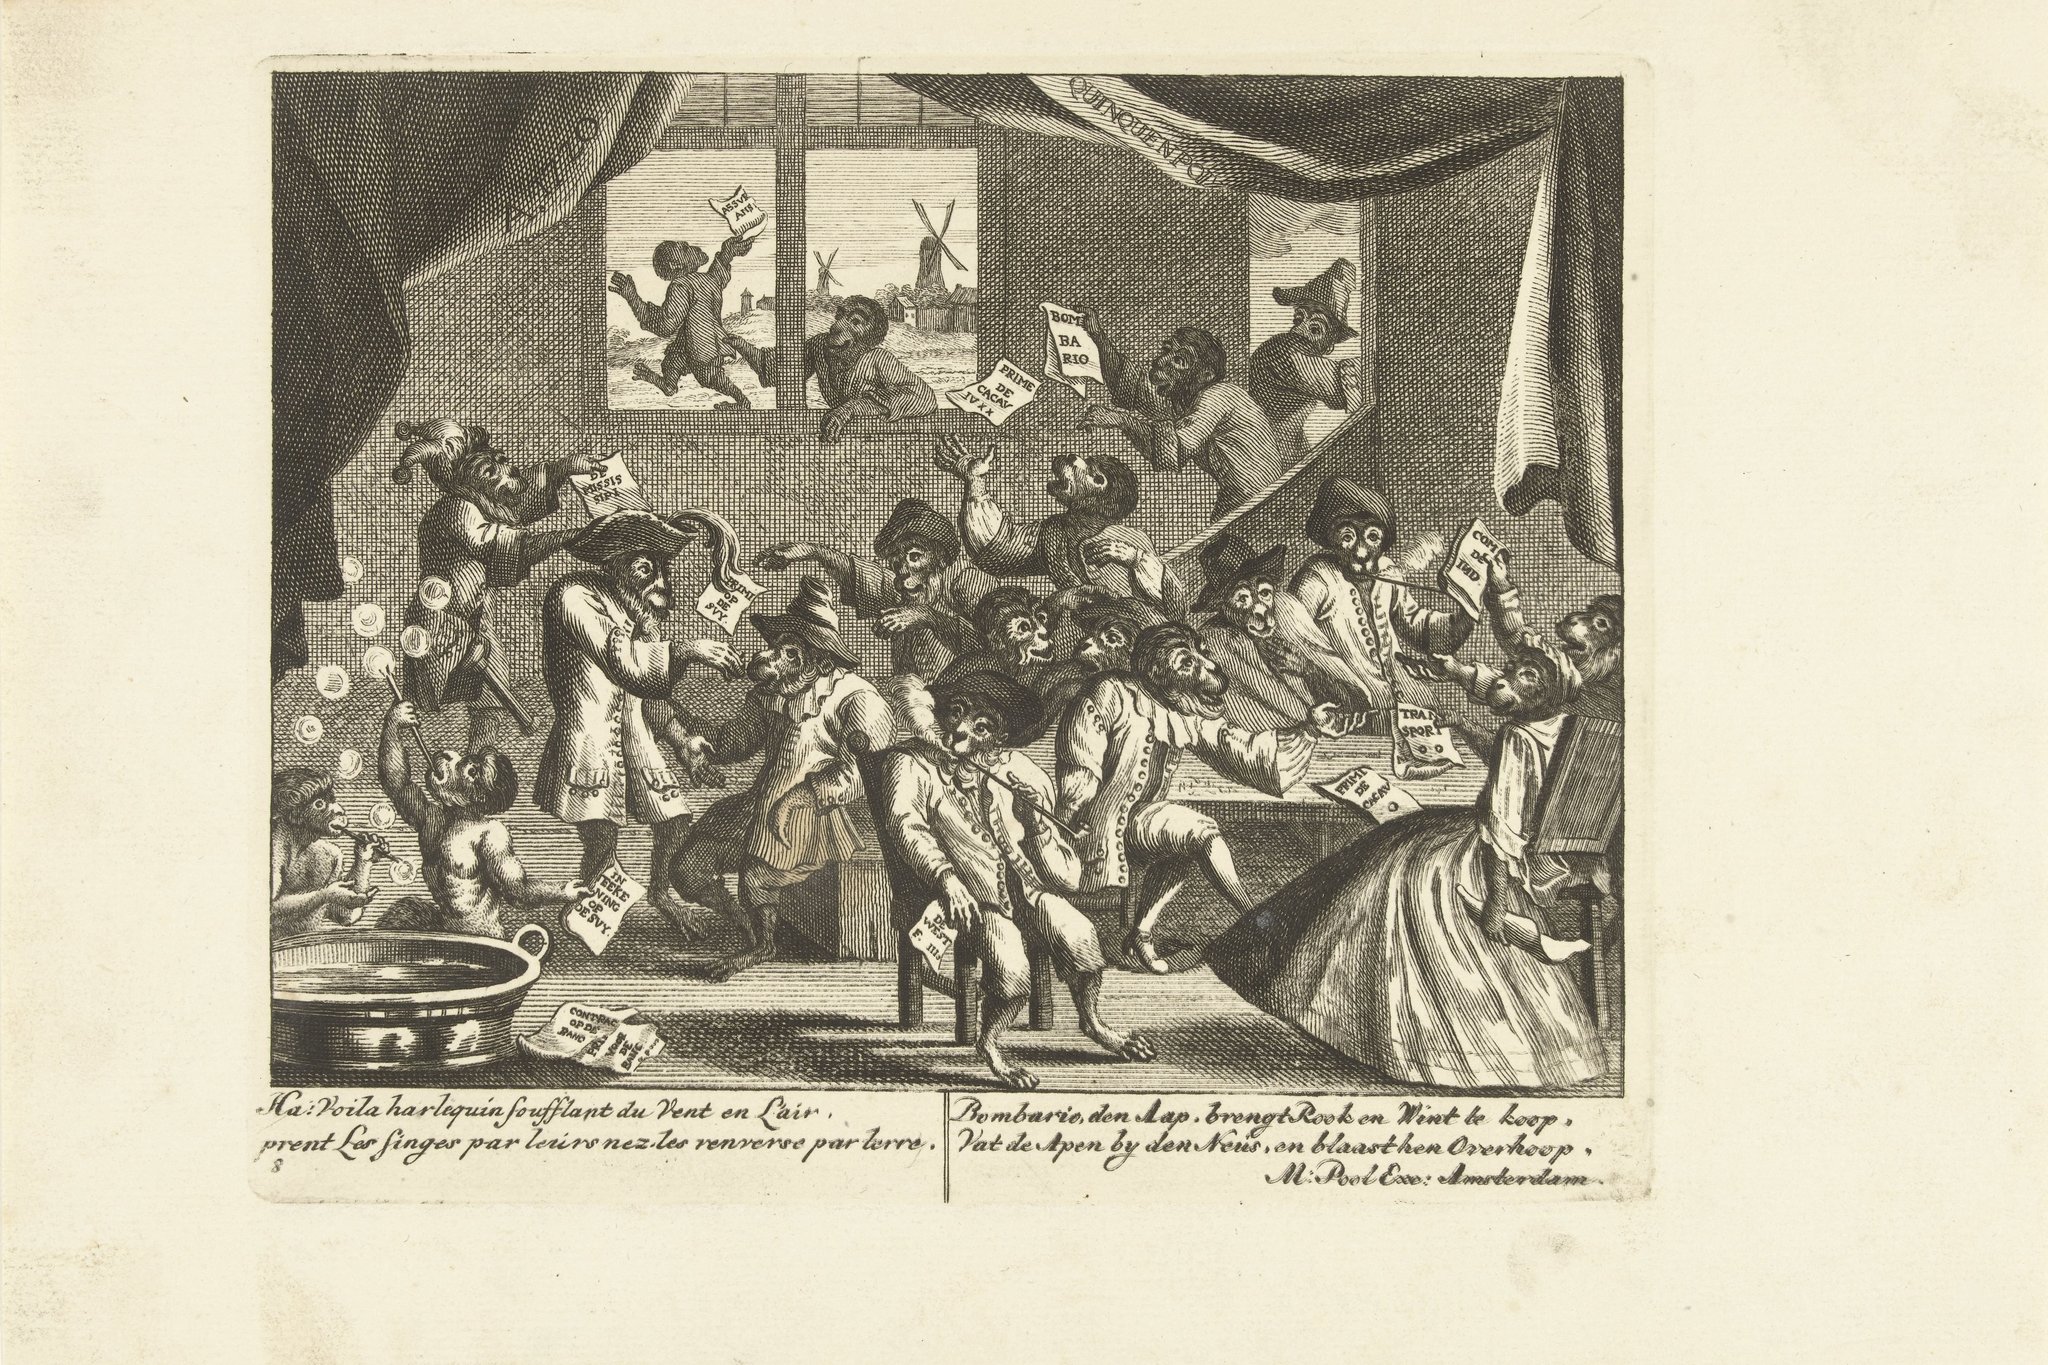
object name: print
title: Apen bezig met de windhandel, ca. 1720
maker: matthijs pool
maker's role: print maker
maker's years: 1676-1740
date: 1720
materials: paper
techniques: engraving, etching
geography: amsterdam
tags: financial panic, speculative boom, monkeys, apes, animals acting as human beings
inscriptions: collector's mark: Lugt 2228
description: Apen bezig met de windhandel. In het onderschrift versjes in het Frans en Nederlands. Prent nr. 8 in een serie van 16 prenten van ca. 1720 waarin apen als mensen figureren in allerlei huishoudelijke taferelen.